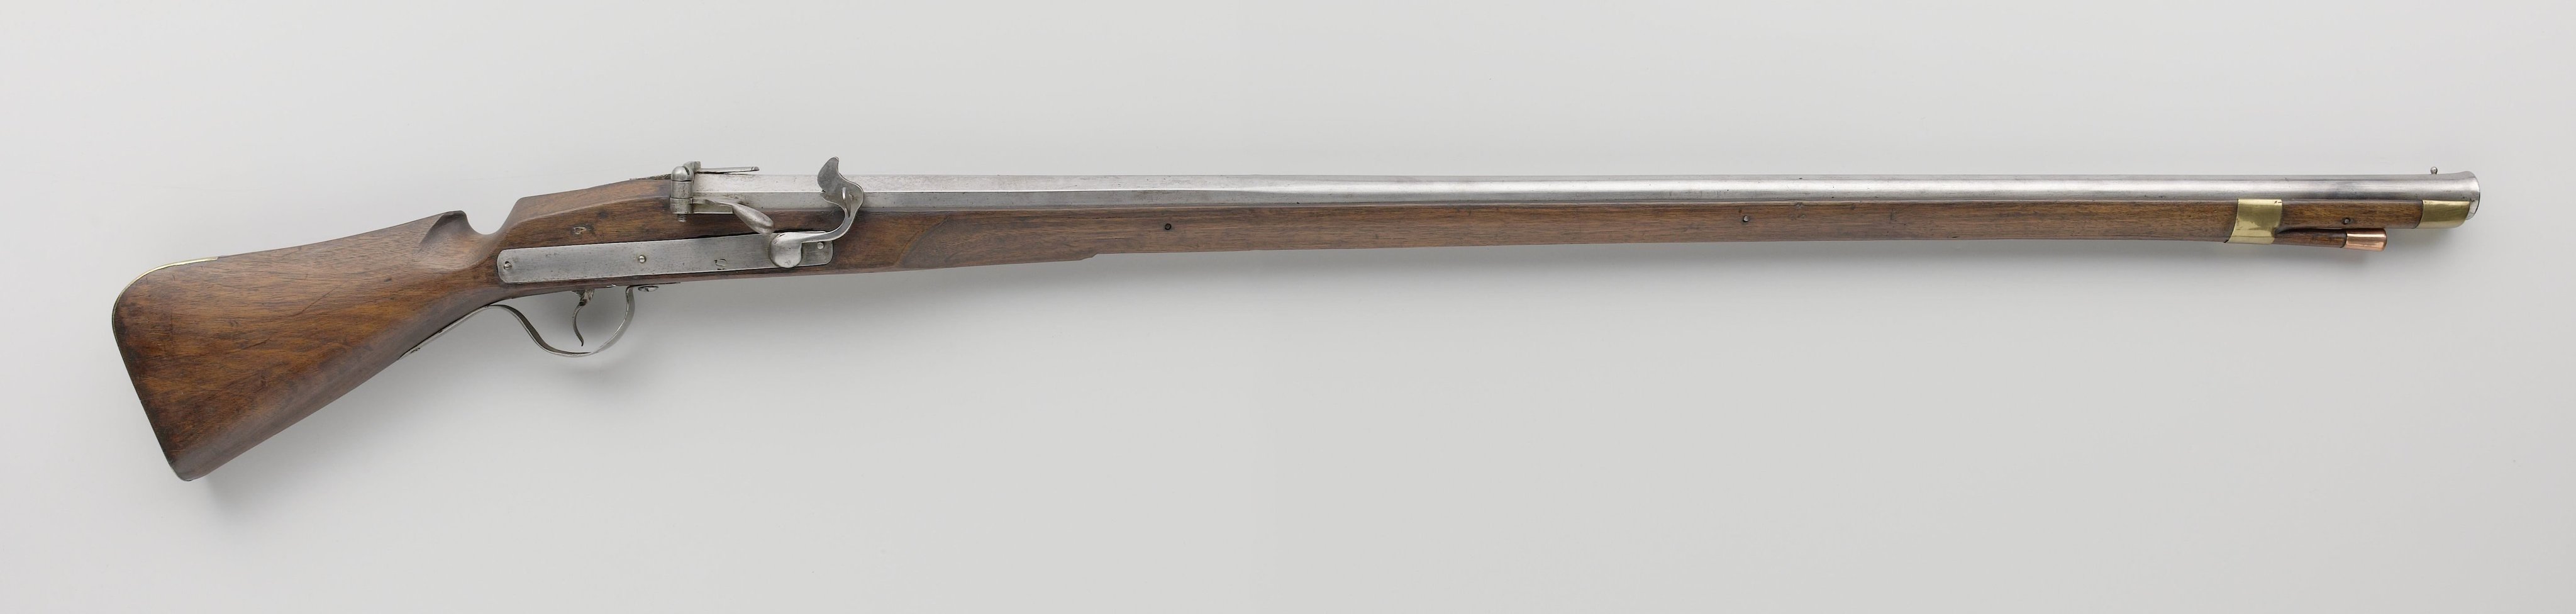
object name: lontslotwapen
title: Musket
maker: Anonymous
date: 1625-1650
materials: brass, iron, wood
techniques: cutting, forging, striking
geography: netherlands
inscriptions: mark: ‘niet leesbaar’, mark: ‘NM’, number: ‘B.L. 12’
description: Musket, probably made in the Netherlands, second quarter 17th century.